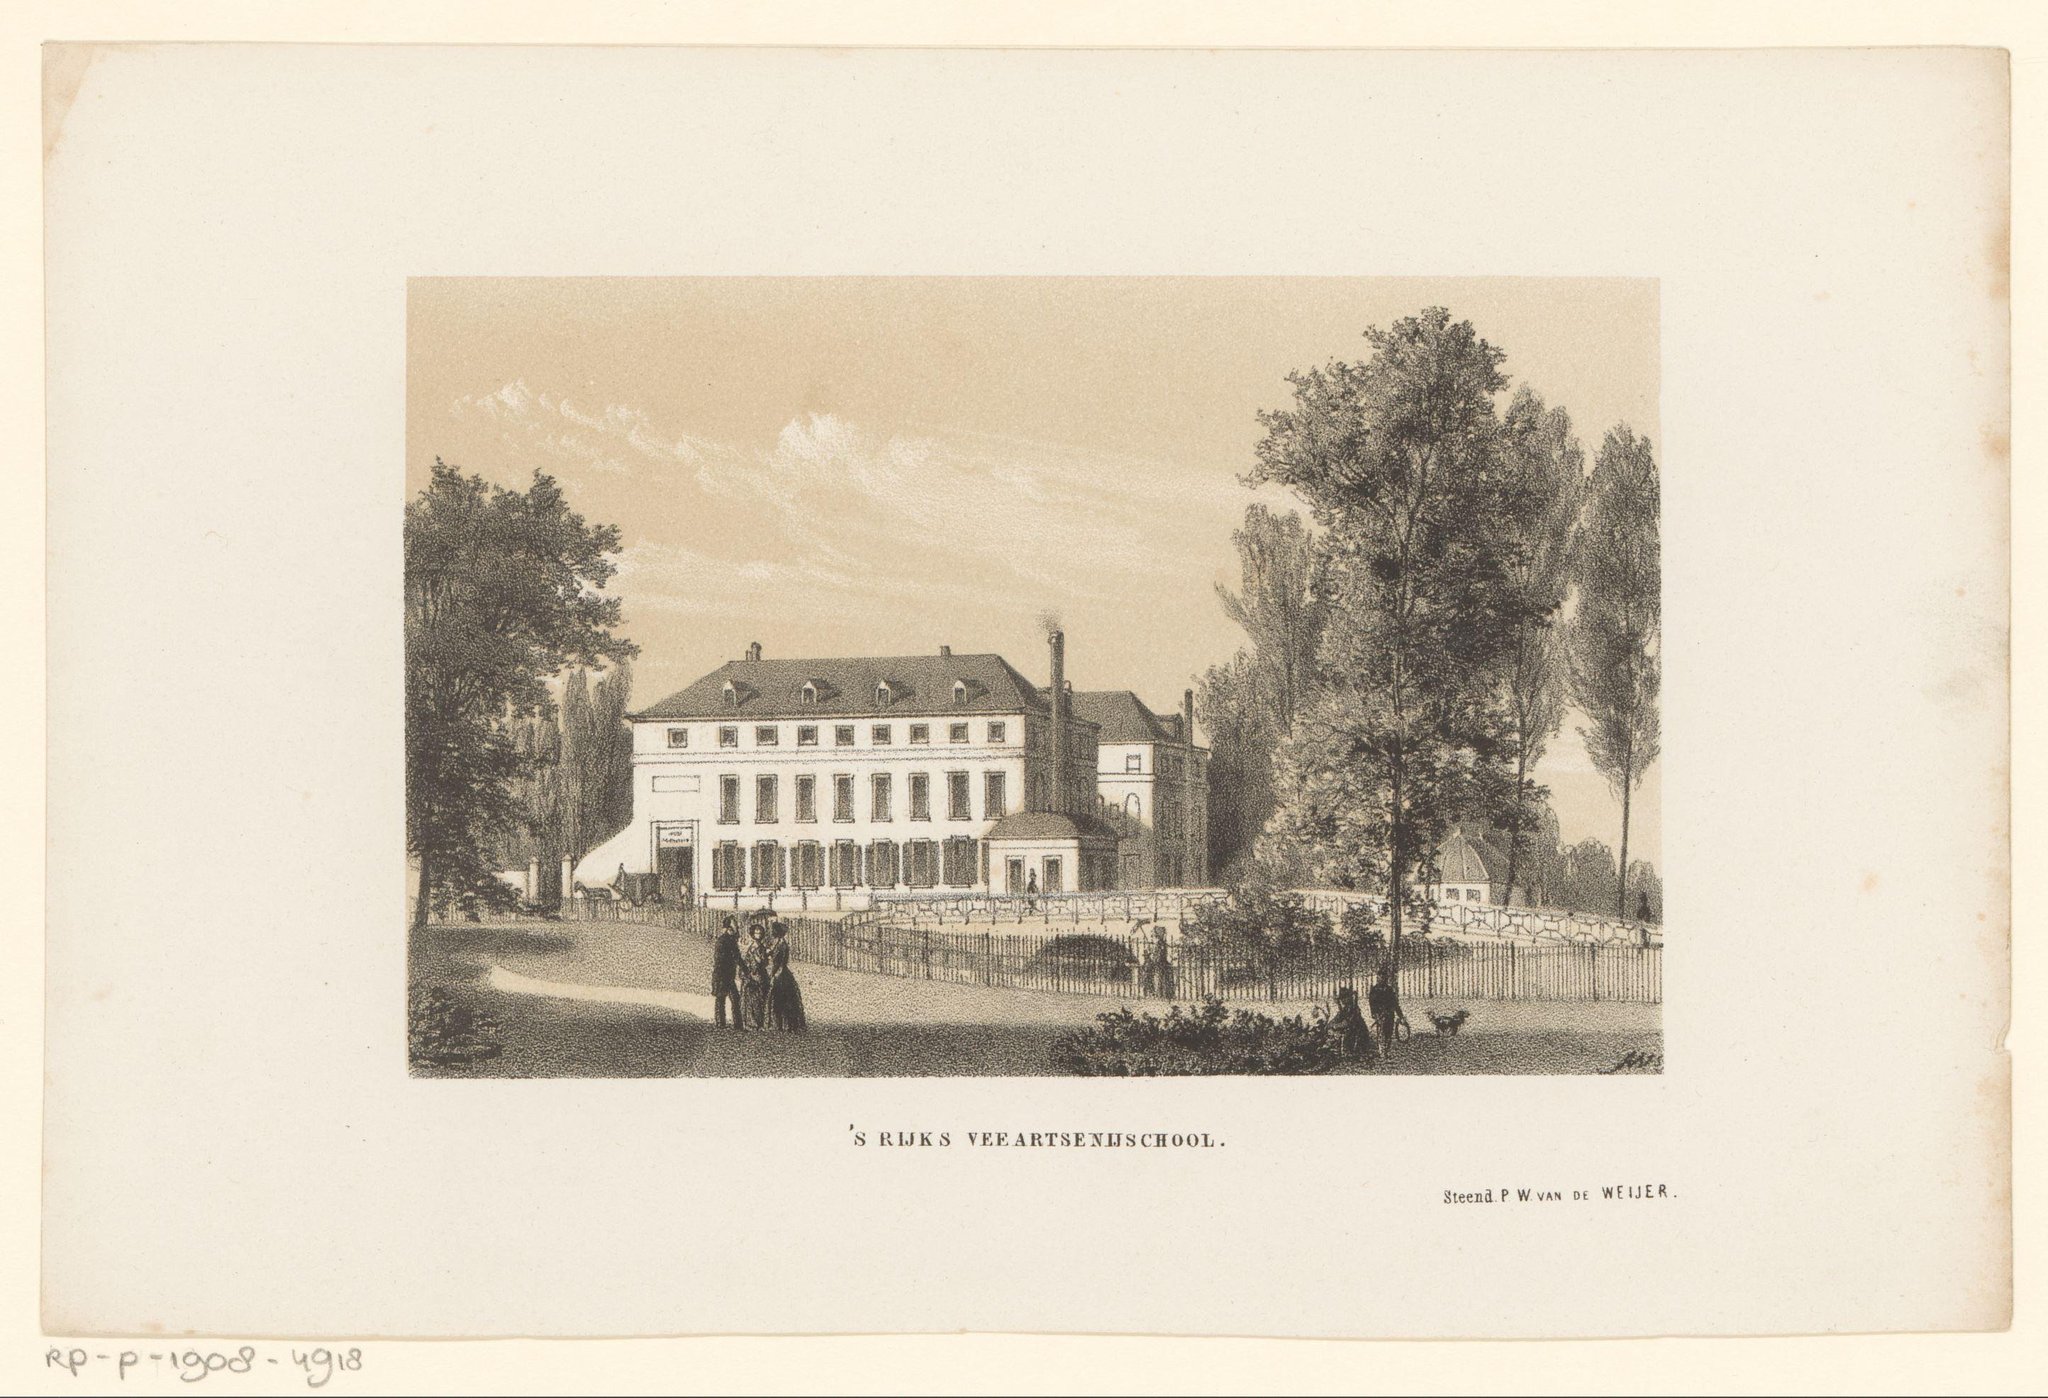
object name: print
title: 's Rijks veeartsenijschool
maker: pieter wilhelmus van de weijer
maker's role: print maker, printer, publisher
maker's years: 1816-1880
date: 1856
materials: paper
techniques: tone lithography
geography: utrecht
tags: city-view, and landscape with man-made constructions, utrecht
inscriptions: collector's mark: Lugt 2228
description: Mogelijk maakte deze prent deel uit van: Utrecht's Album, Utrecht: W.F.Dannenfelser, 1856.